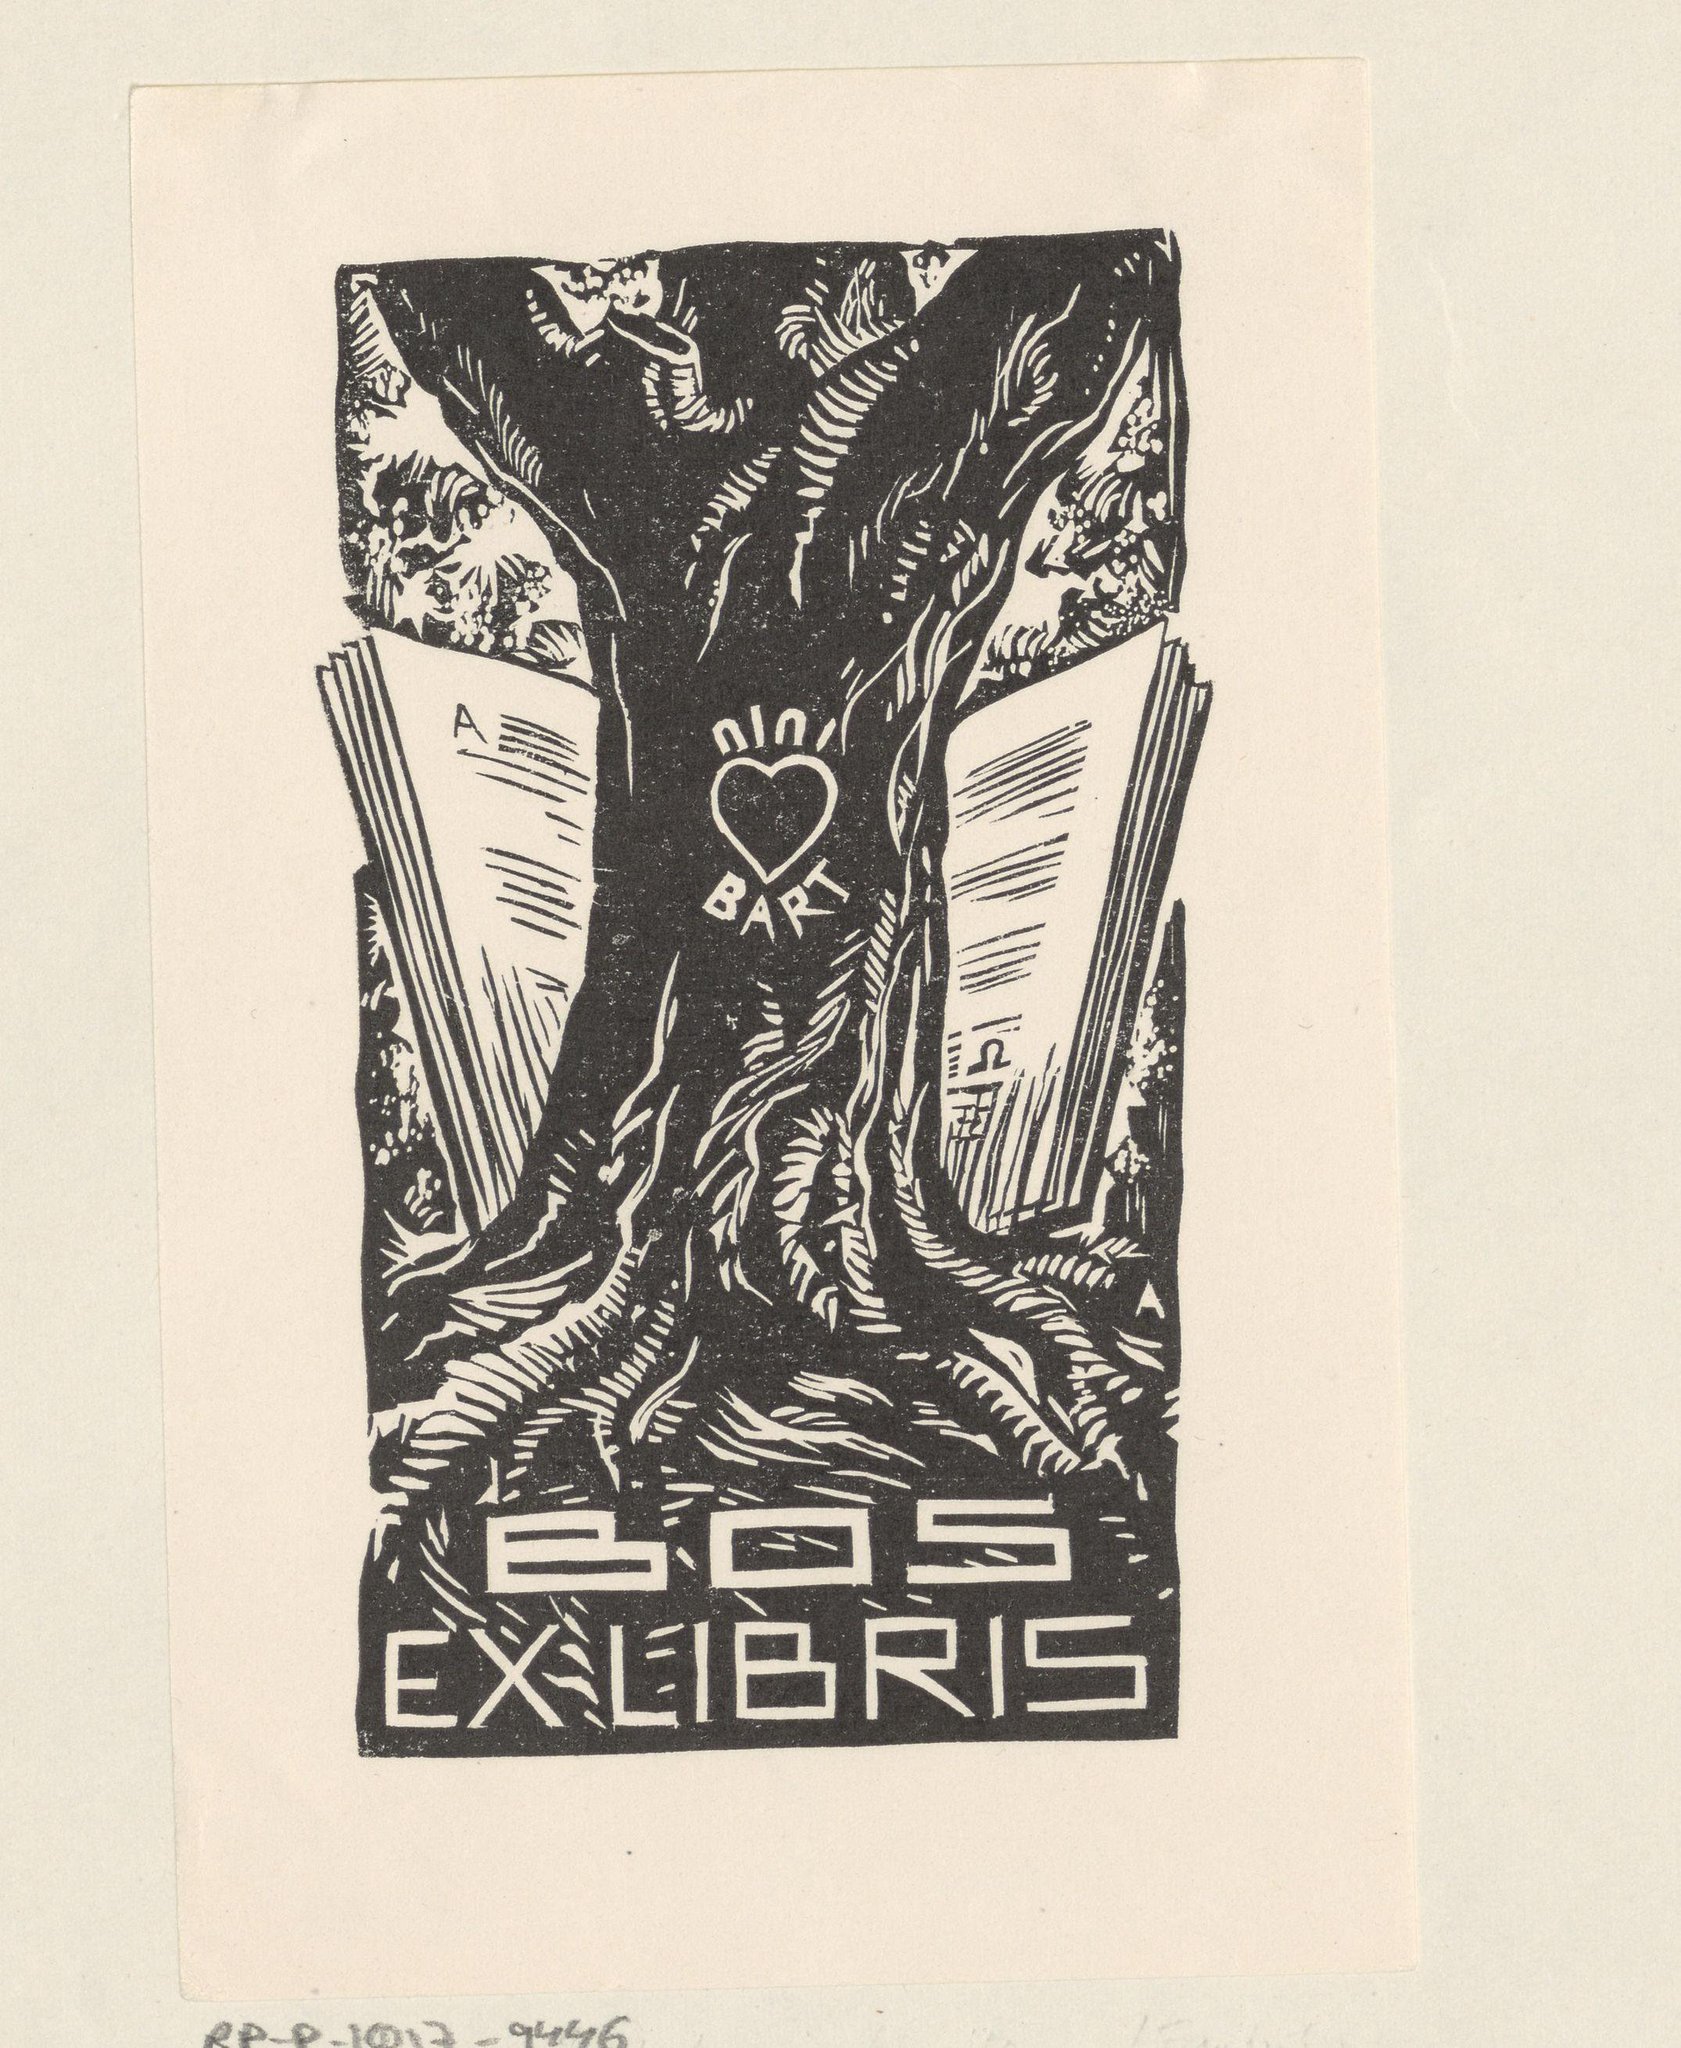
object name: bookplate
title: Ex libris van Nini en Bart Bos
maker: françois d aquin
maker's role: print maker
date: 1950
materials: paper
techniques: woodcut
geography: france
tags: bart bos, book, plants and herbs, alpha and omega ~ symbol of god the father